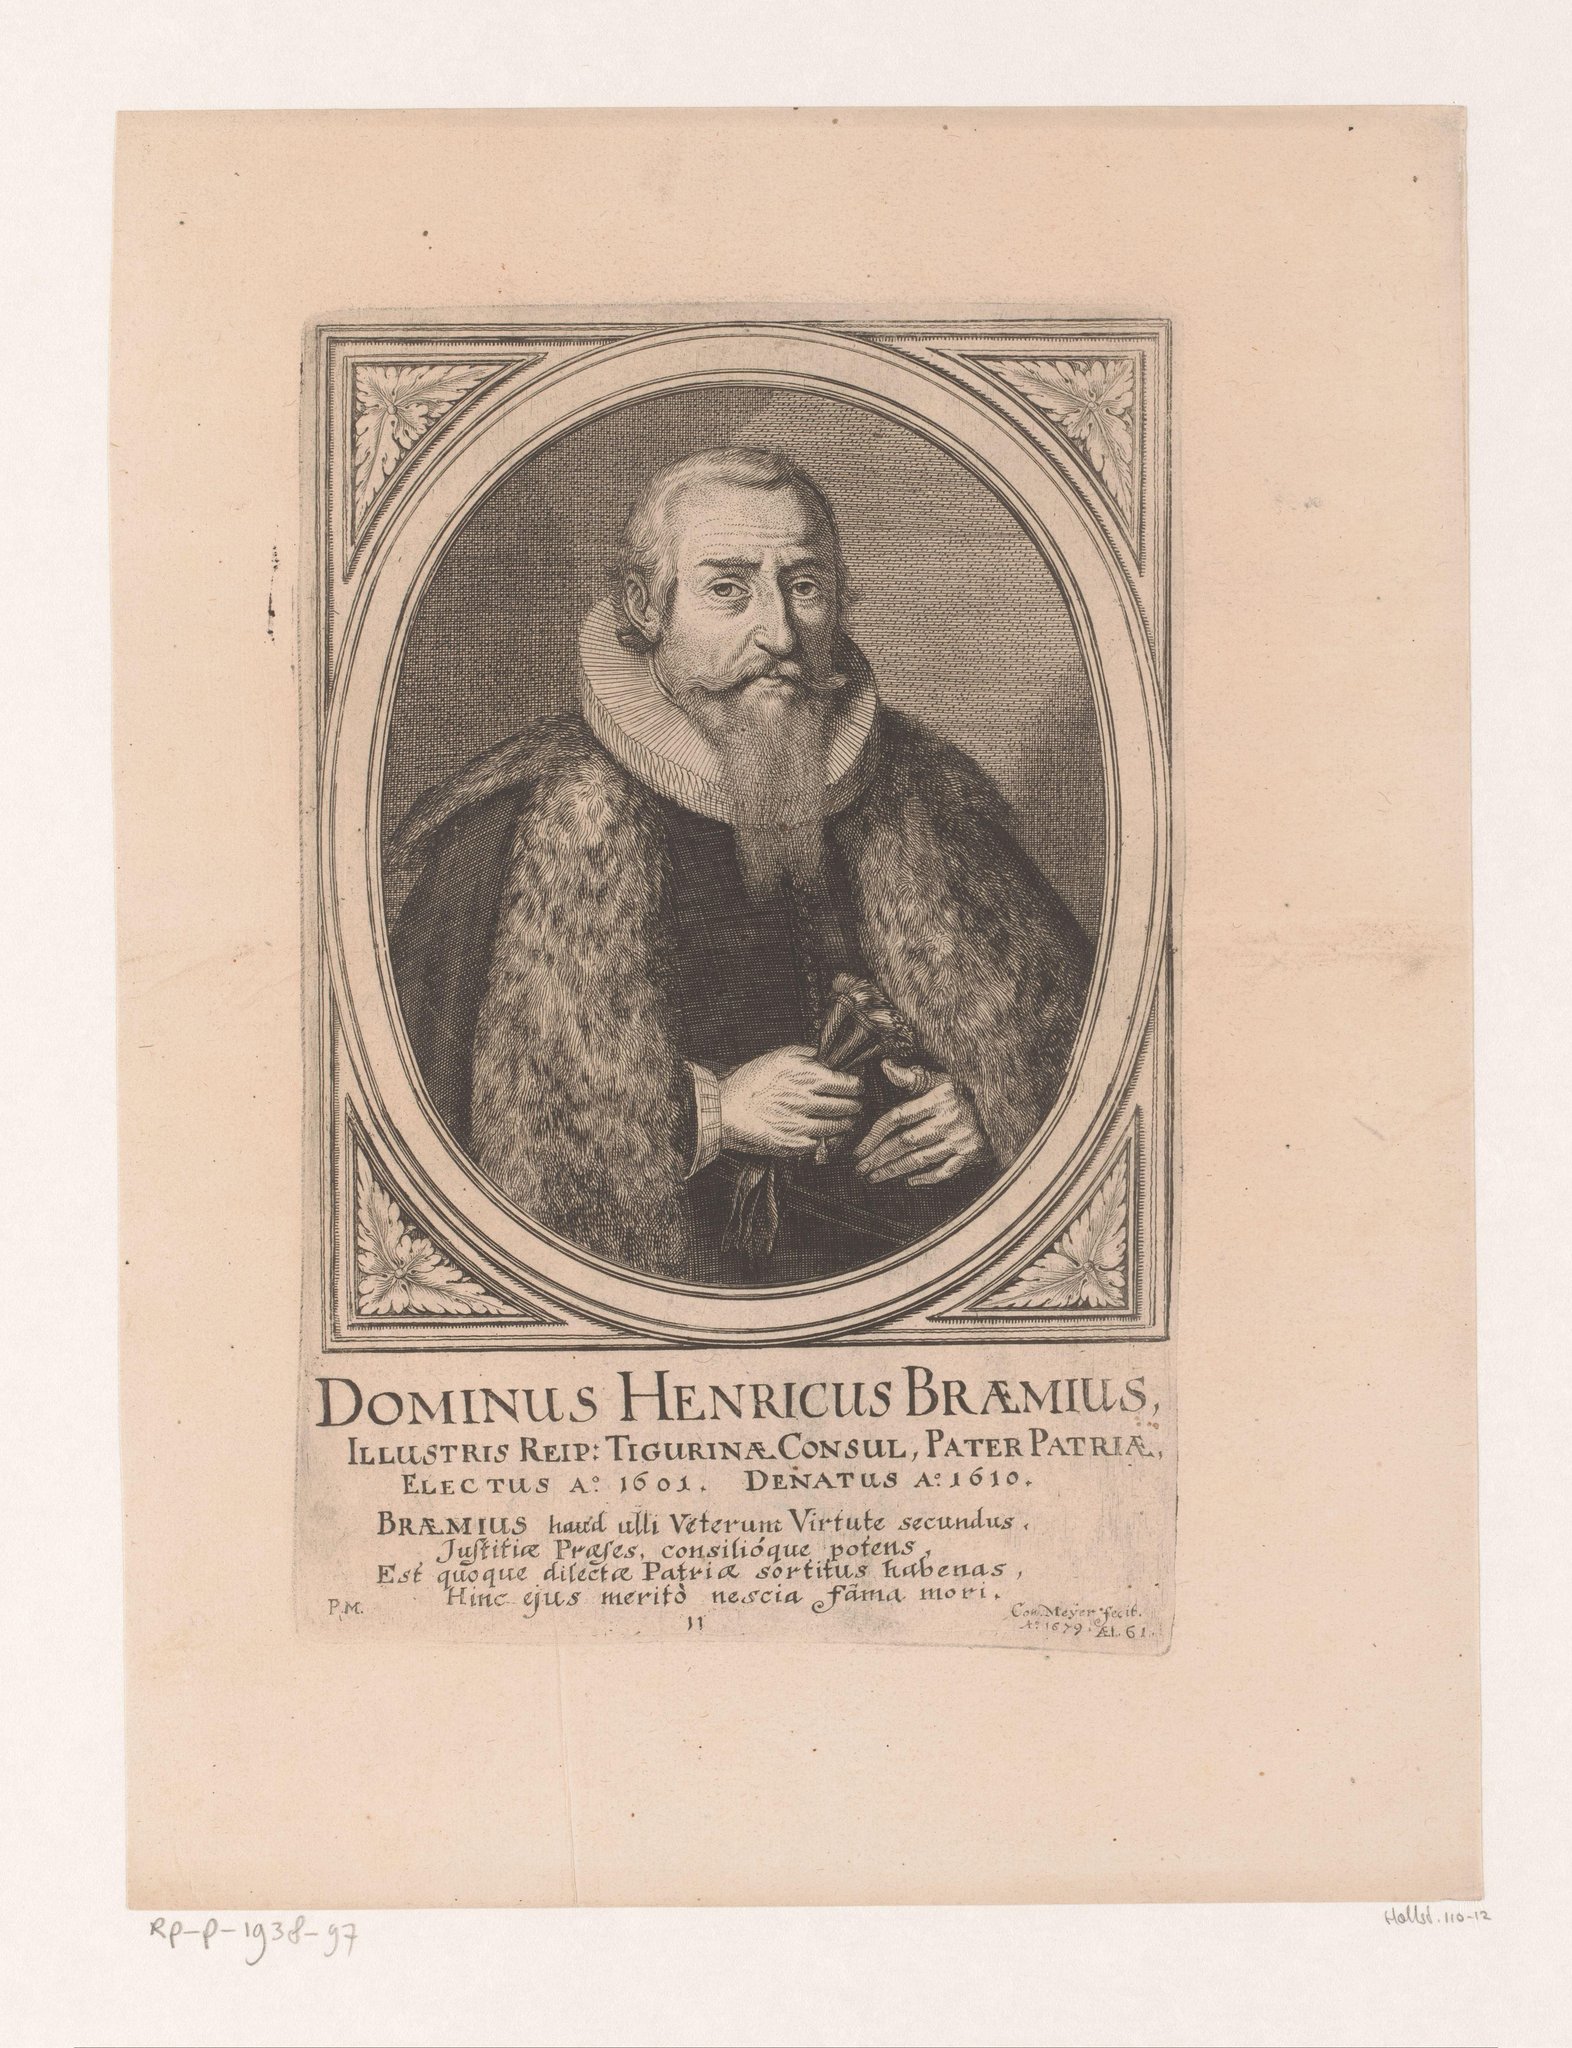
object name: print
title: Portretten van burgemeesters van Zürich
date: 1679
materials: paper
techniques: engraving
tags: mayor, gloves, mittens, etc., historical persons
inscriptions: collector's mark: Lugt 2228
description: Onderdeel van een serie van 67(?) portretten van burgemeesters van Zürich. Zie Hollstein German 110, 1-26.